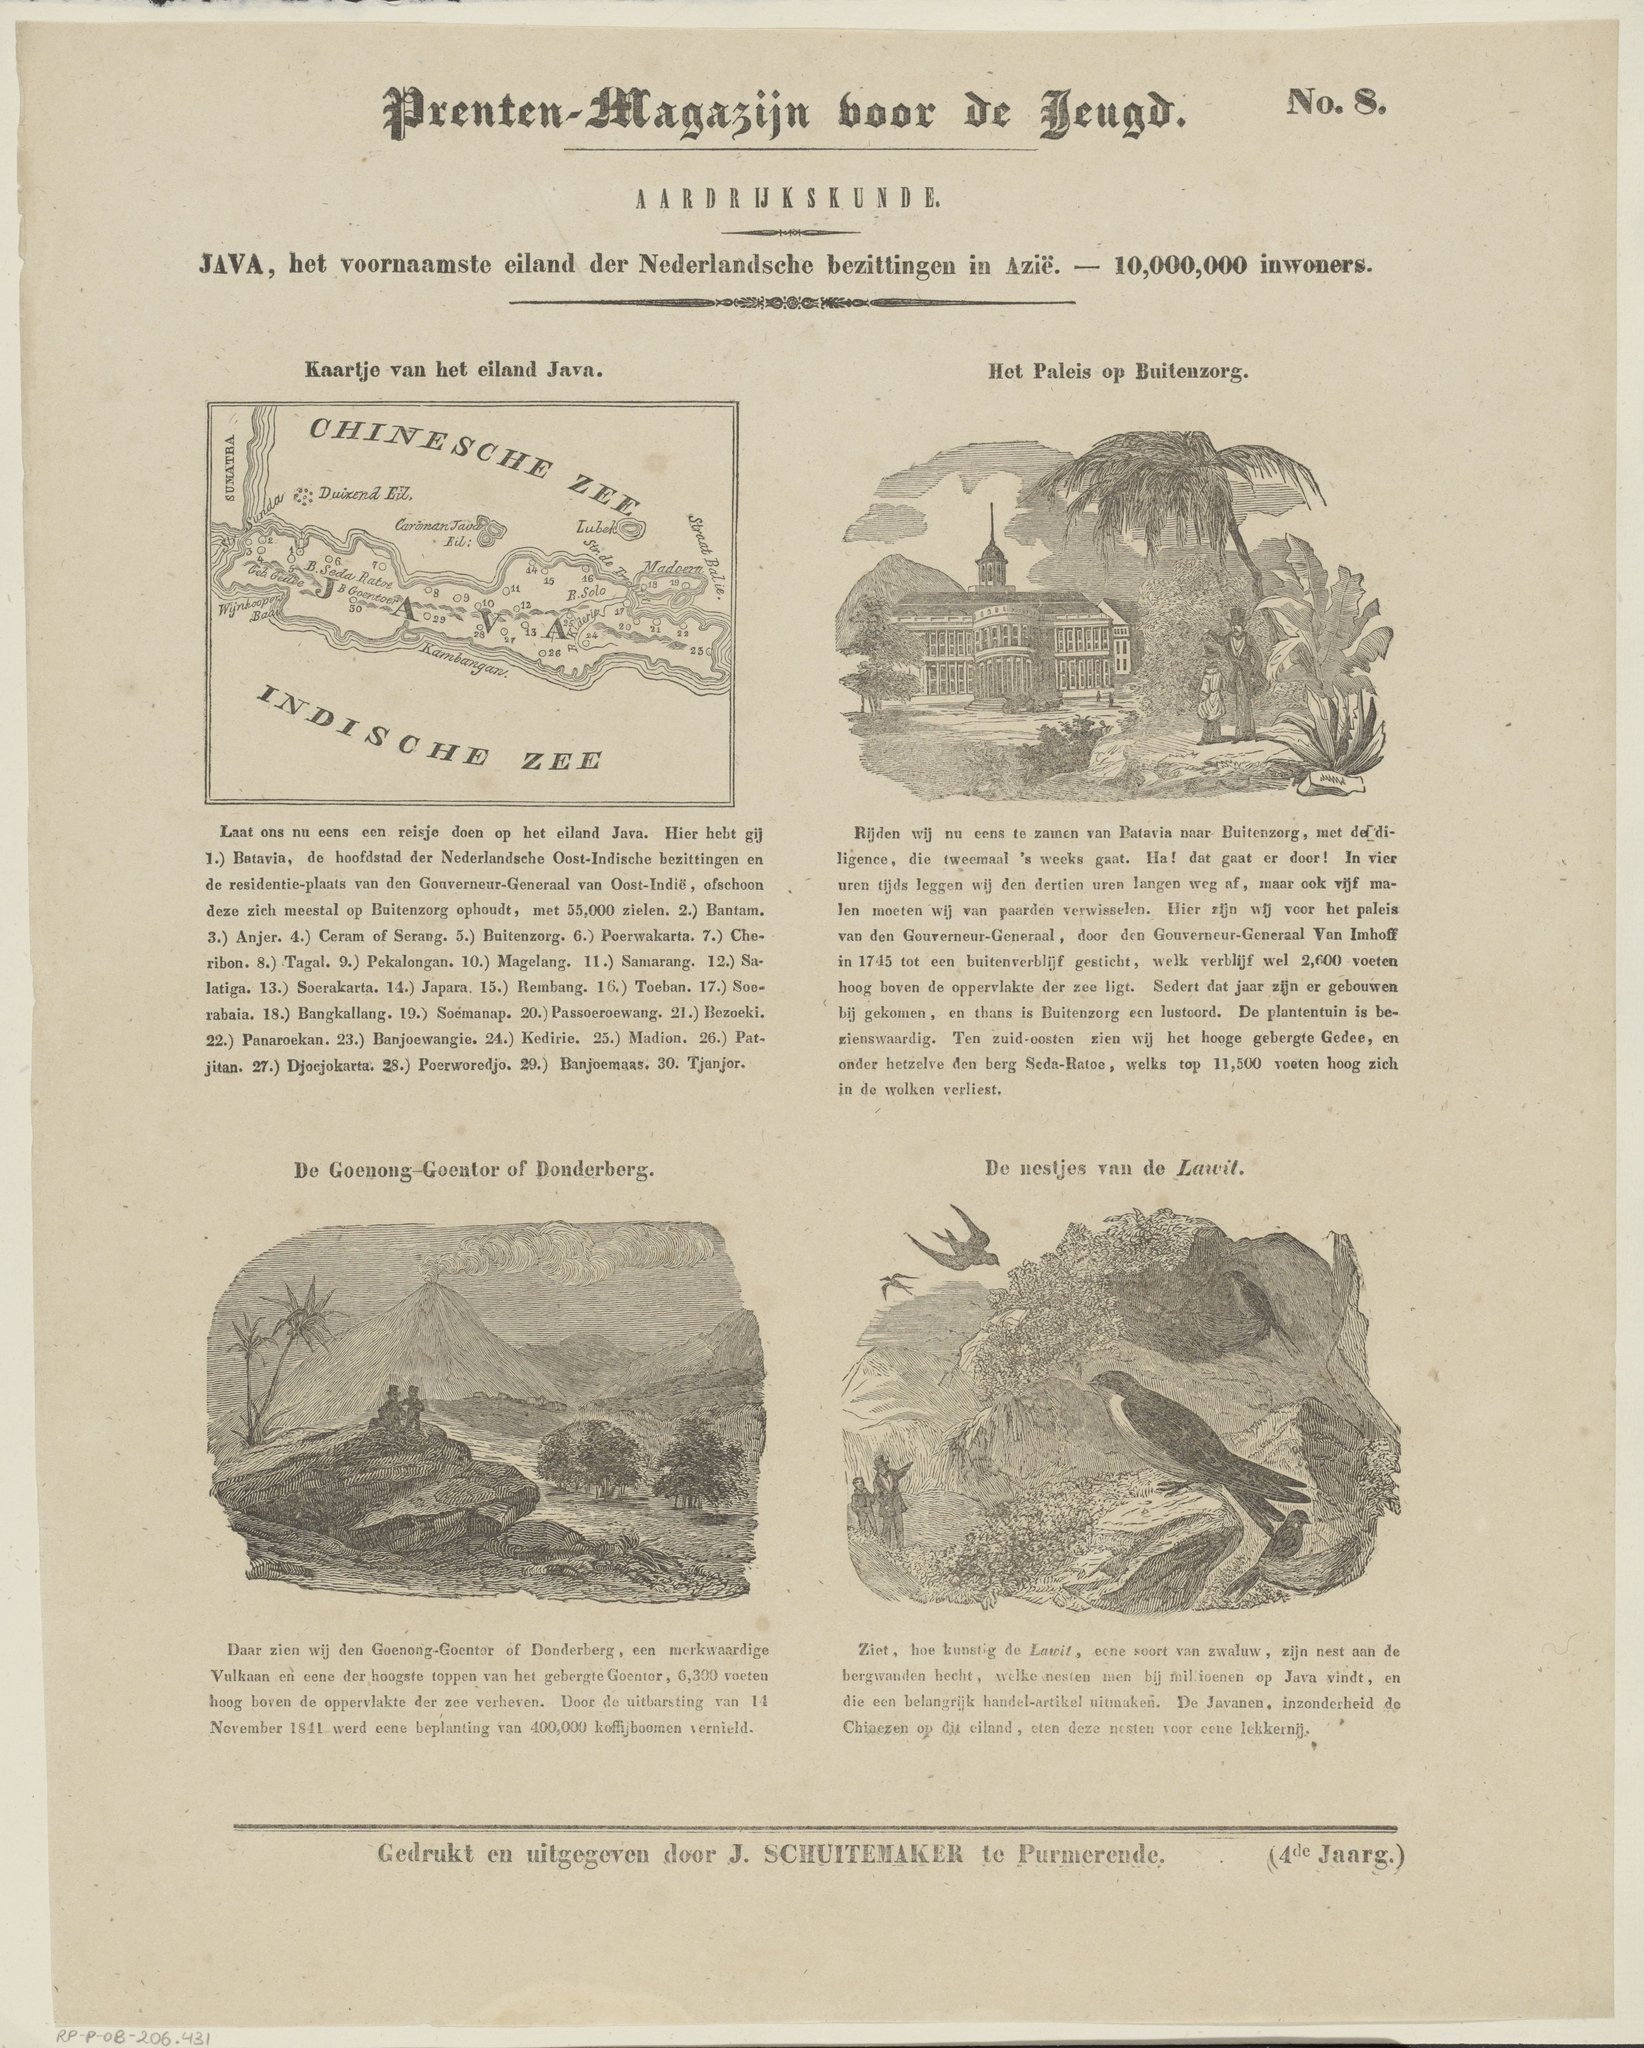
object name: print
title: Aardrijkskunde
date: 1845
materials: paper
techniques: letterpress printing, engraving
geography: netherlands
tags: colonial system, birds, maps, atlases, volcano, java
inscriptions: collector's mark: Lugt 2760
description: Blad met 4 voorstellingen van Java: een kaart, het paleis van de Gouverneur-Generaal in Buitenzorg, de Goenong-Goentor vulkaan en vogels. Boven elke voorstelling een titel en onder elke voorstelling een onderschrift. Genummerd rechtsboven: No. 8.